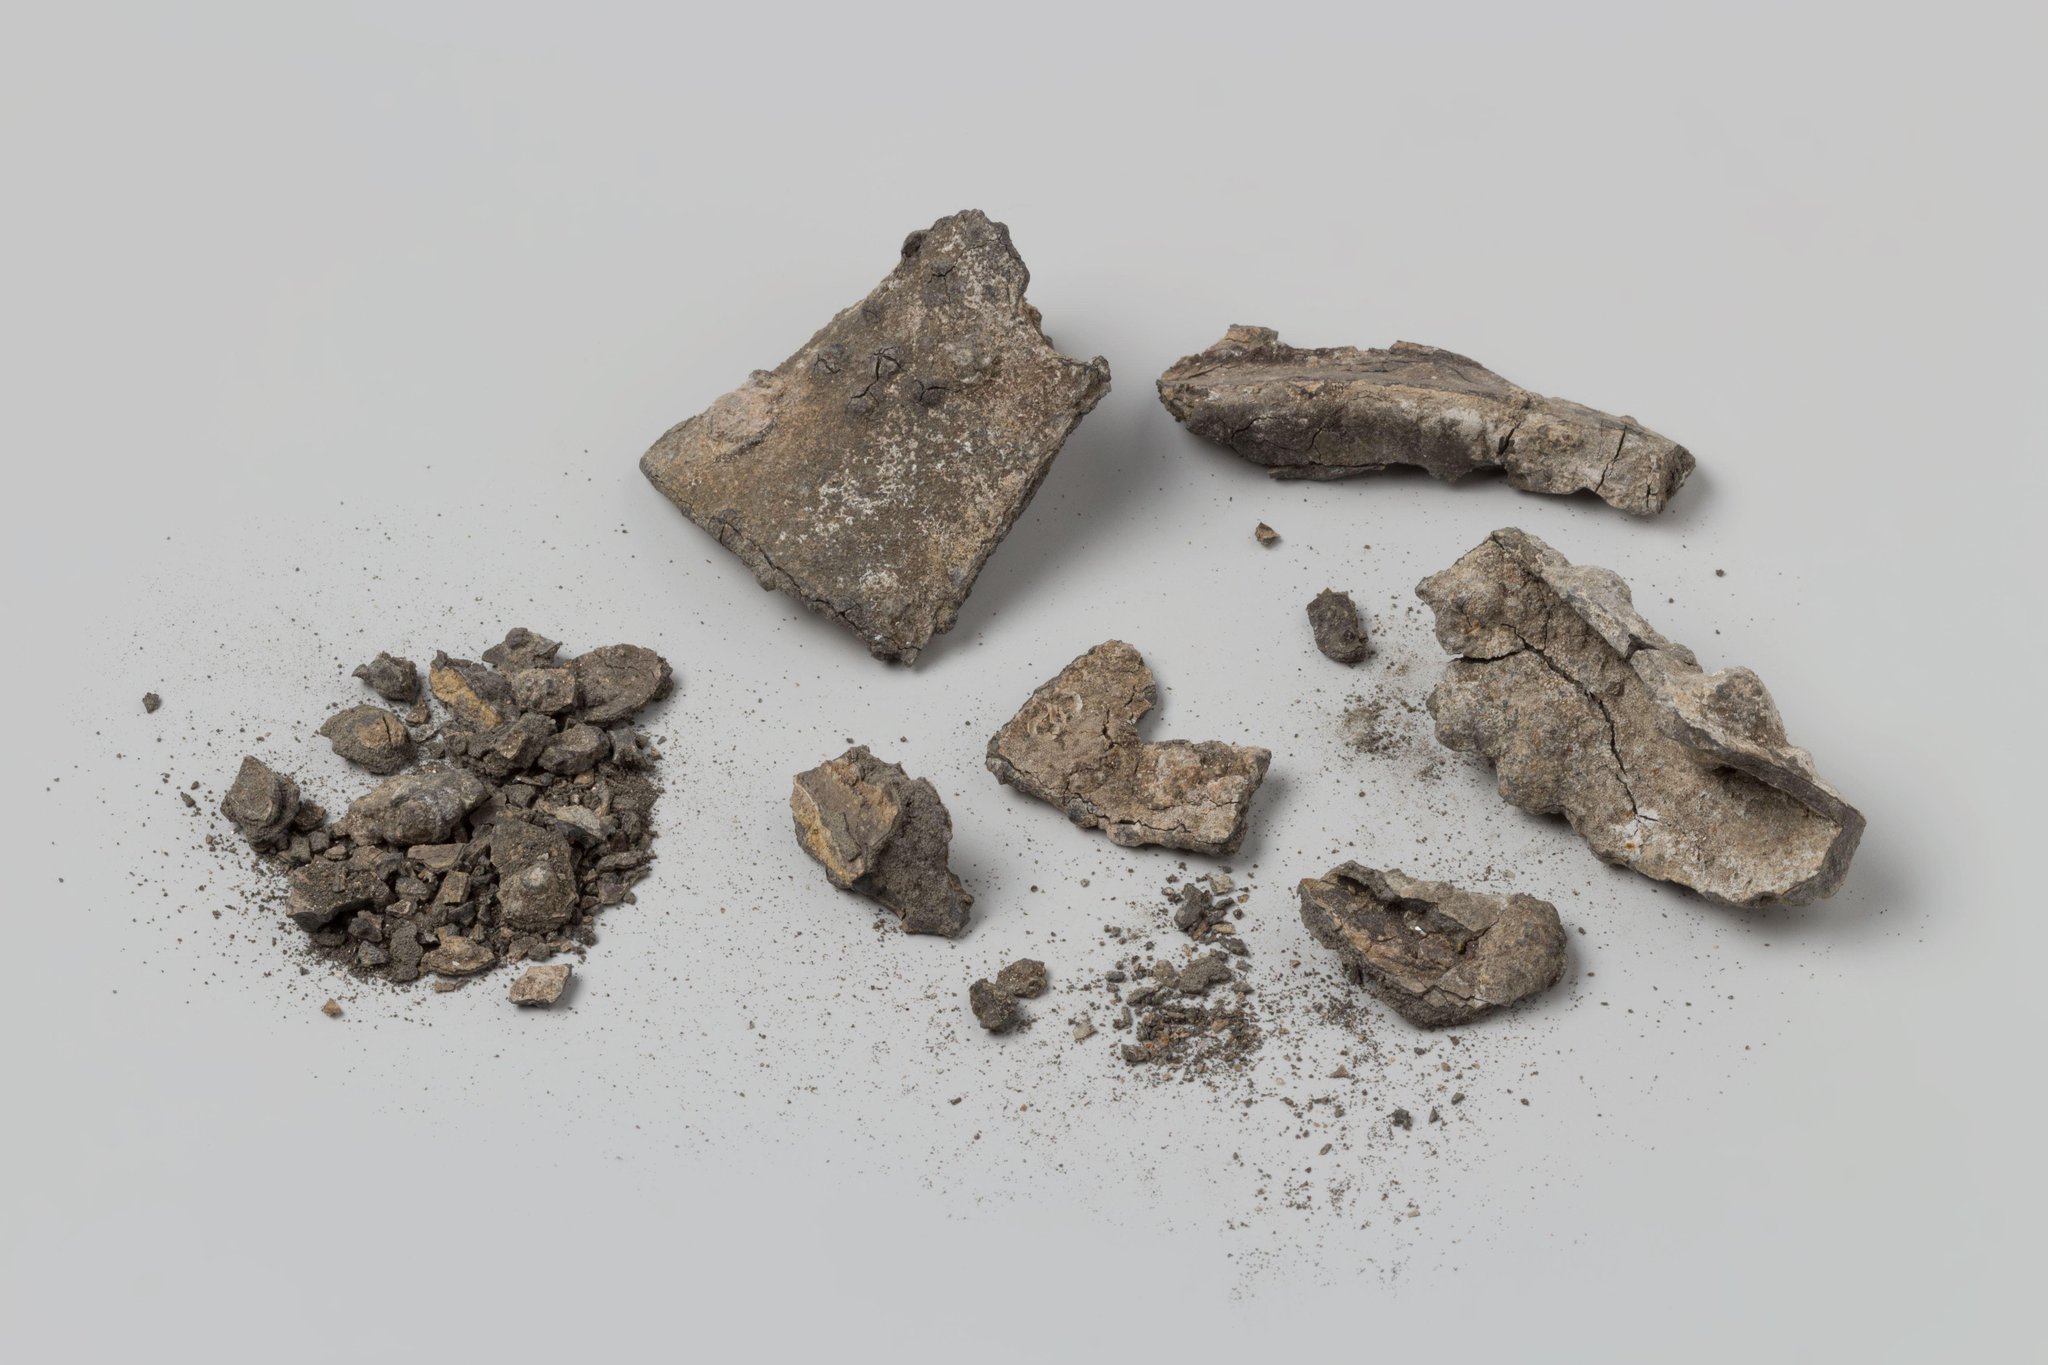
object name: fragment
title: Fragmenten van metaal uit V.O.C.-schip de 'Witte Leeuw'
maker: Anonymous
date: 1613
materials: metal, tin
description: Zes metaalfragmenten en een zakje met gruis. Fragiel.